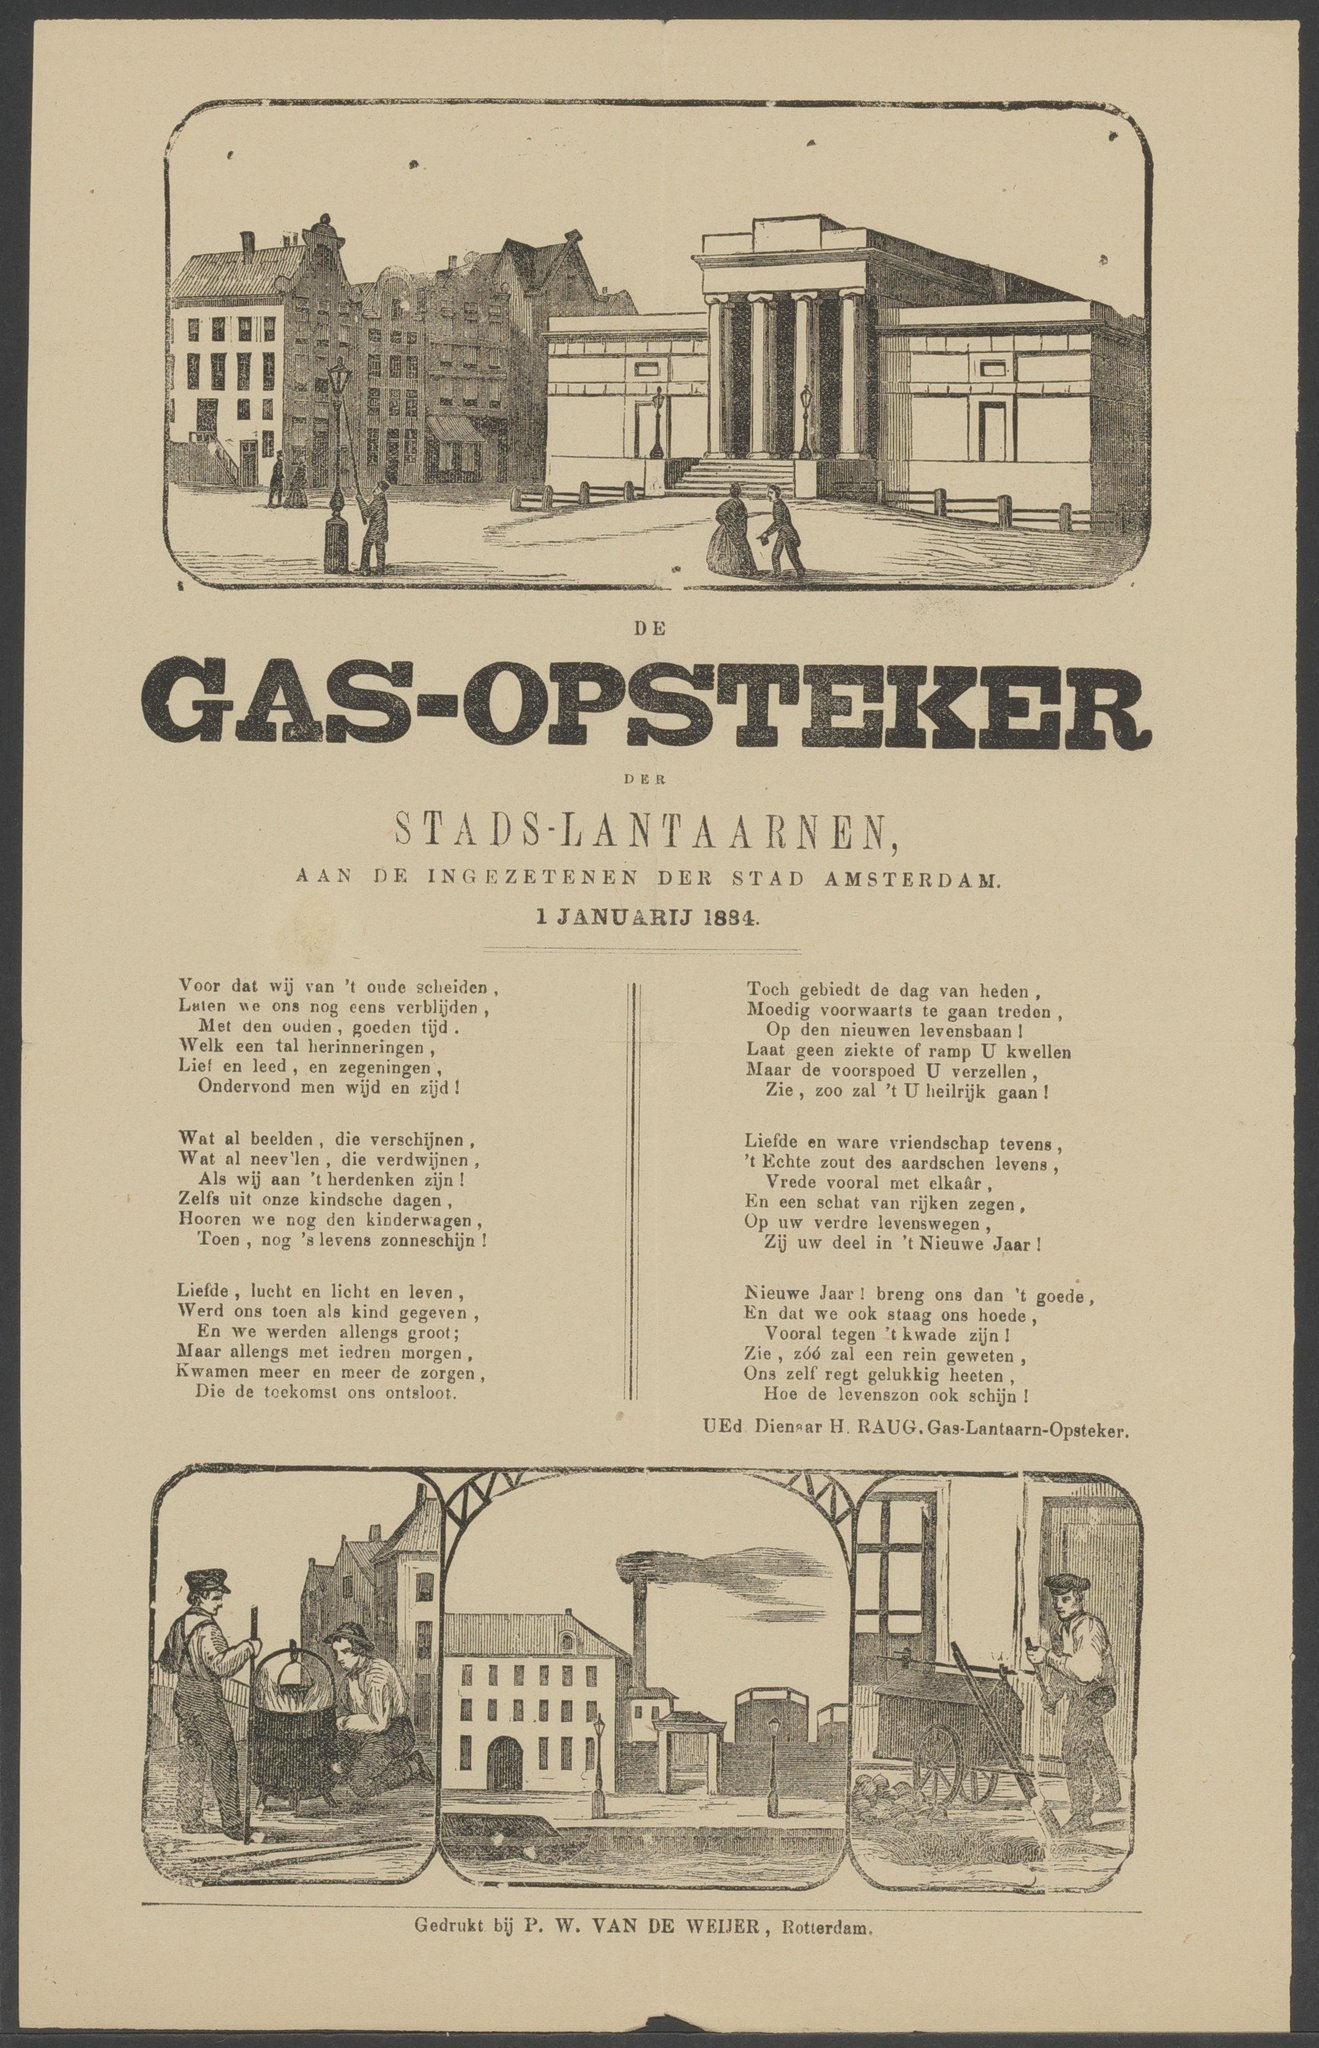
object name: print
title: Nieuwjaarswens van de gaslantaarnopstekers van Amsterdam voor het jaar 1884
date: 1883-1884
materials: paper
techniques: letterpress printing, engraving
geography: rotterdam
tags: gas-lamp, gas supply, digging (industrial process), street lighting, amsterdam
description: Nieuwjaarswens van de Amsterdamse gaslantaarnopstekers voor het jaar 1884. Centraal een vers in twee kolommen. Bovenaan de Dam met de beurs van Zocher te Amsterdam. Onderaan de Hollandsche Gasfabriek en twee gasfitters aan het werk. Van de gaslantaarnopsteker: H. Raug. Onderwerpsrubrieken binnen de Atlas Zeden en Gewoonten: Zeden en gewoonten in engeren zin, Volksleven, Volksbladen, Nieuwjaars- en Kerstwenschen, Amsterdam.